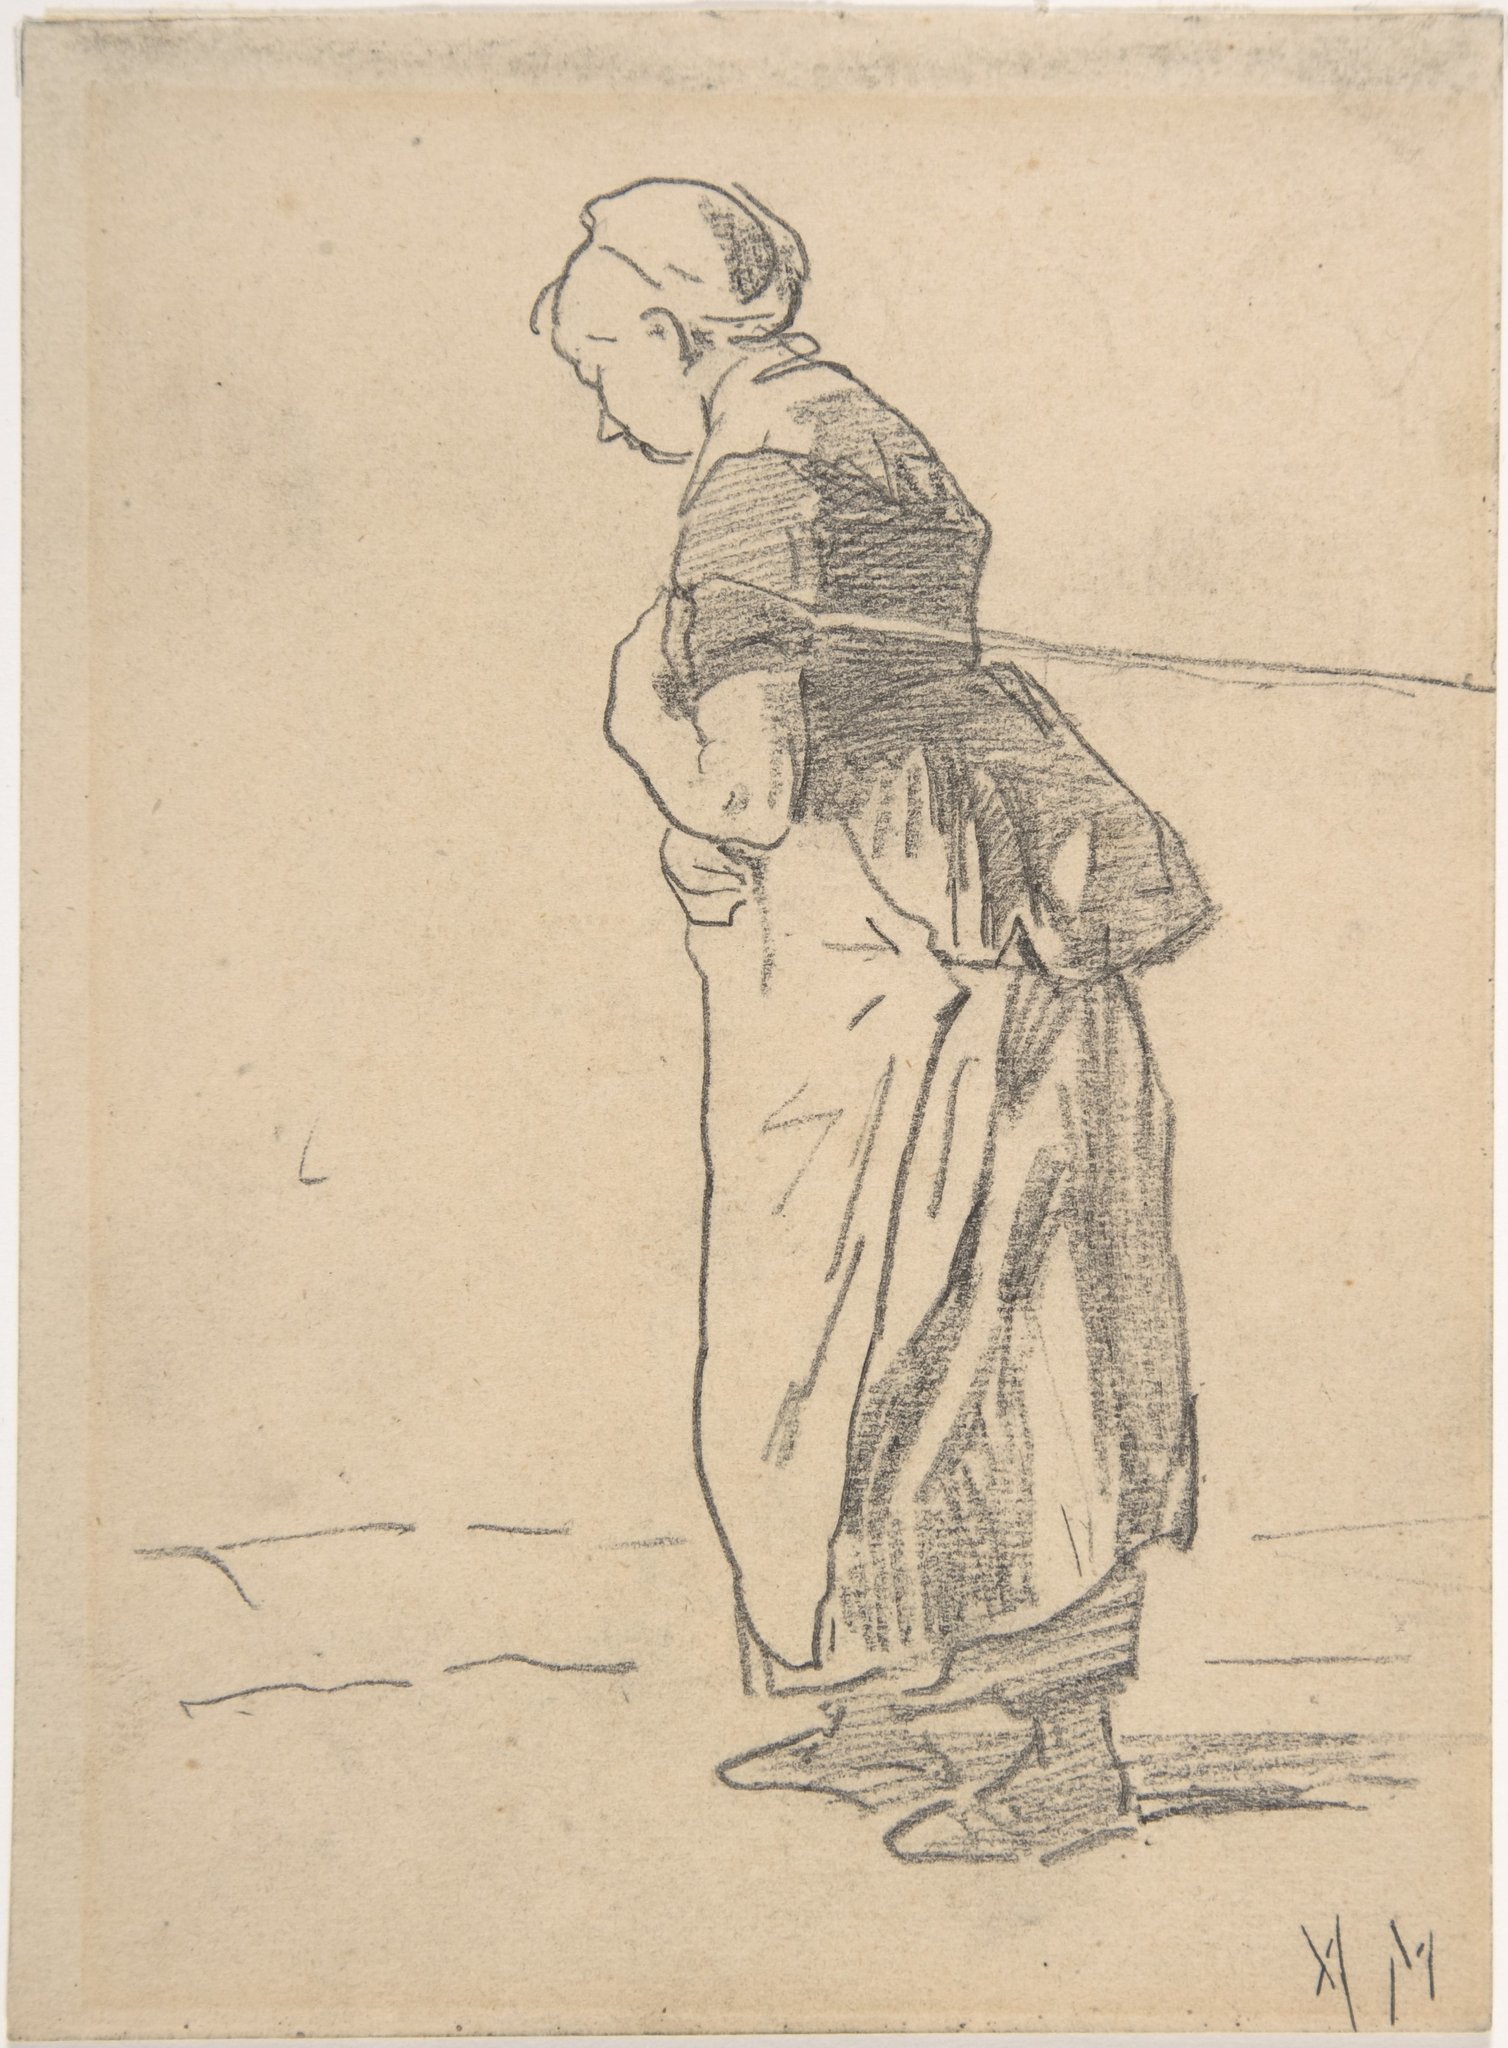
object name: drawing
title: Woman pulling a tow rope. verso: sketch of landscape with figures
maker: anton mauve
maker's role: artist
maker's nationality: dutch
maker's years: 1838-1888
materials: chalk, graphite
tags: women